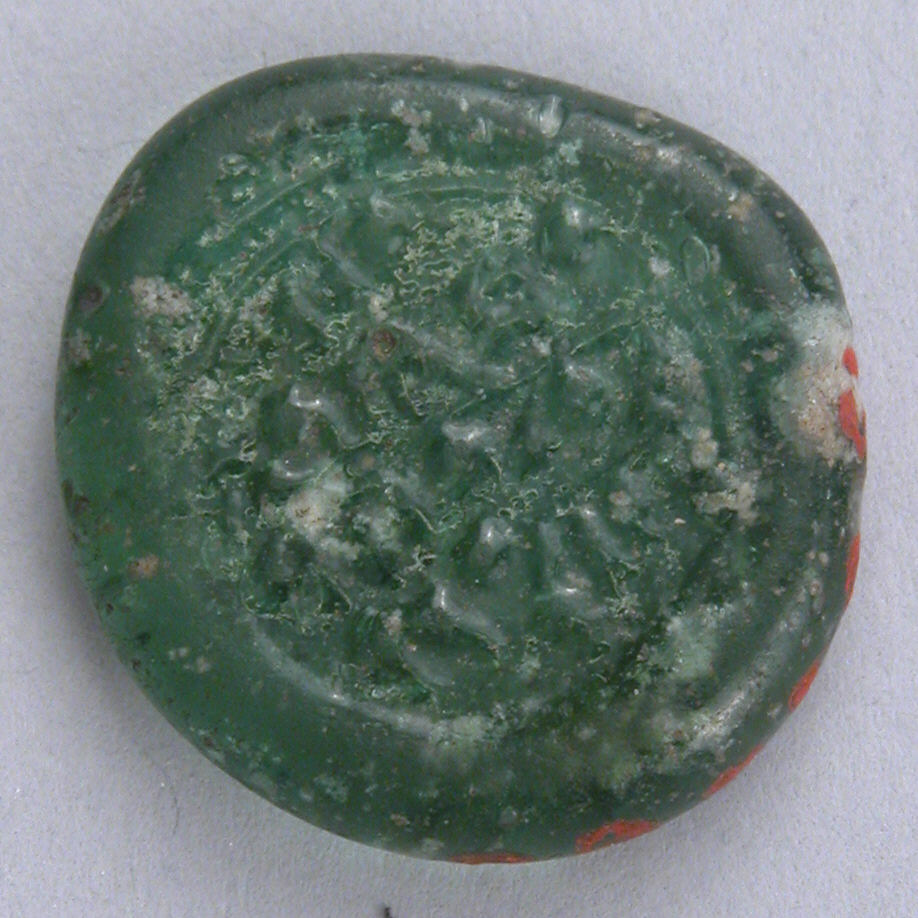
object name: coin weight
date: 1001-1100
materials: glass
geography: egypt